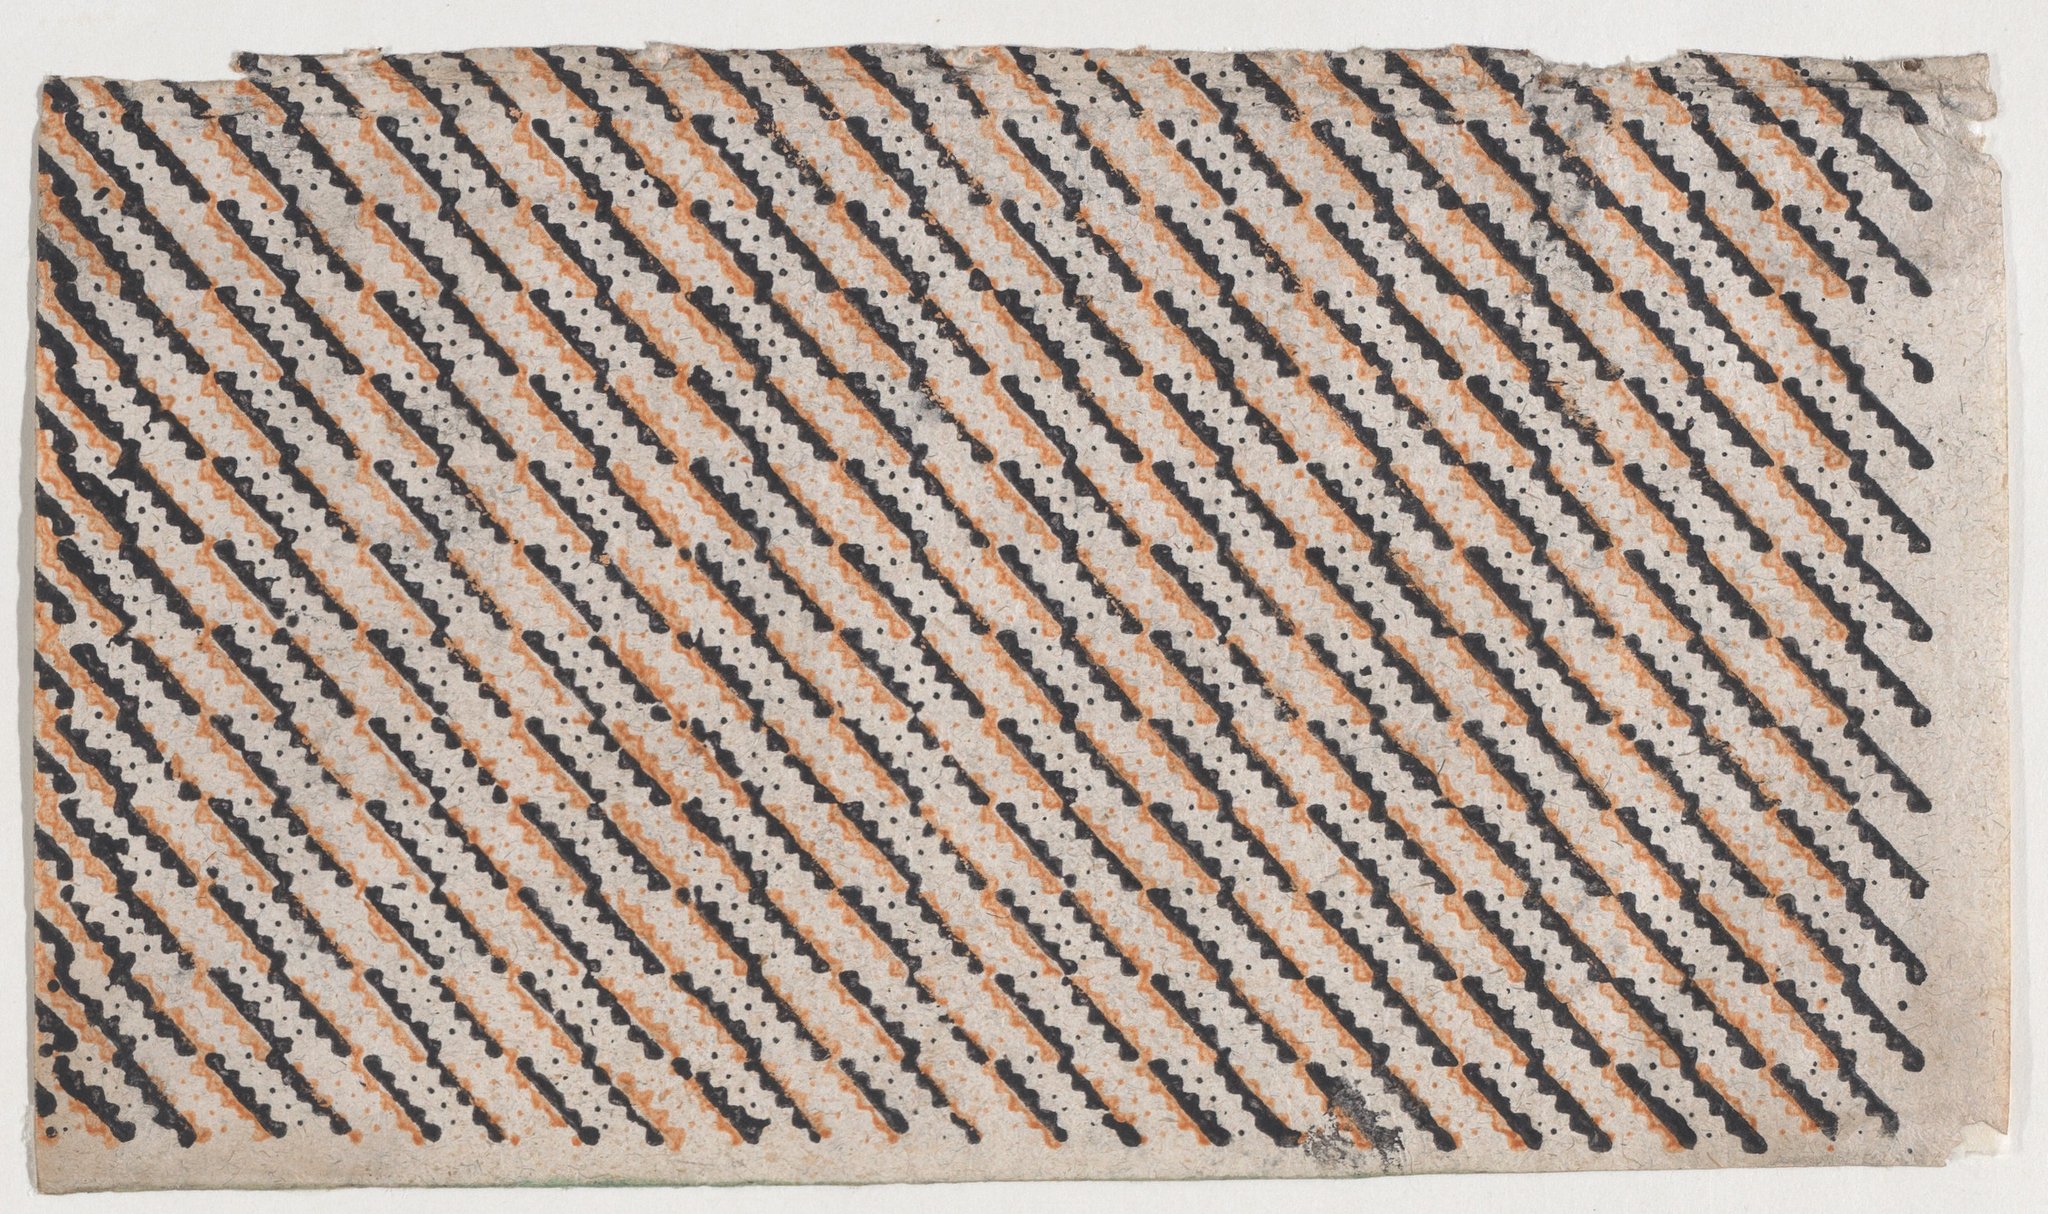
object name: print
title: Sheet with diagonal stripe pattern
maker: Anonymous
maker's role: artist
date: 1801-1900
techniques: relief print